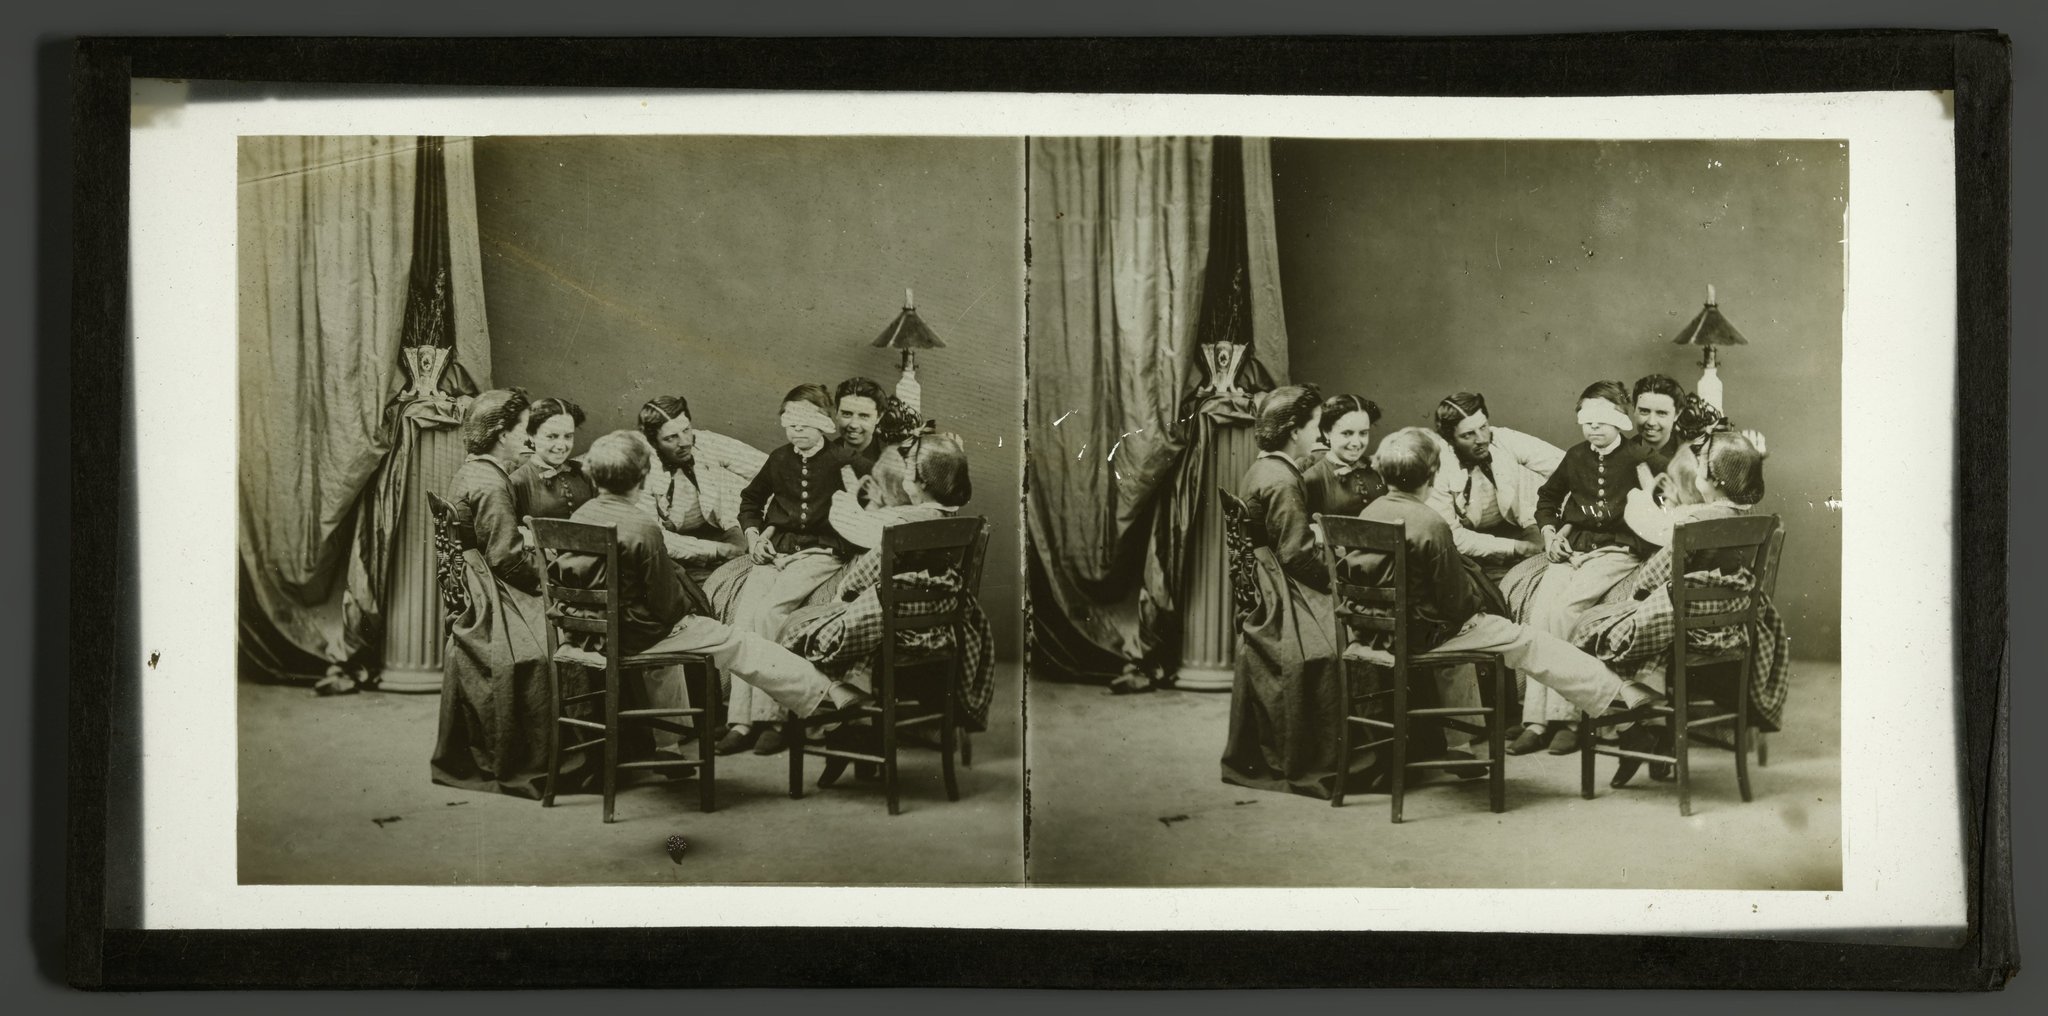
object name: stereoscopic photograph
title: Familie tijdens kinderspelletje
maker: Anonymous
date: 1890-1920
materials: glass, paper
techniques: slide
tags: children's games and plays, family life at home